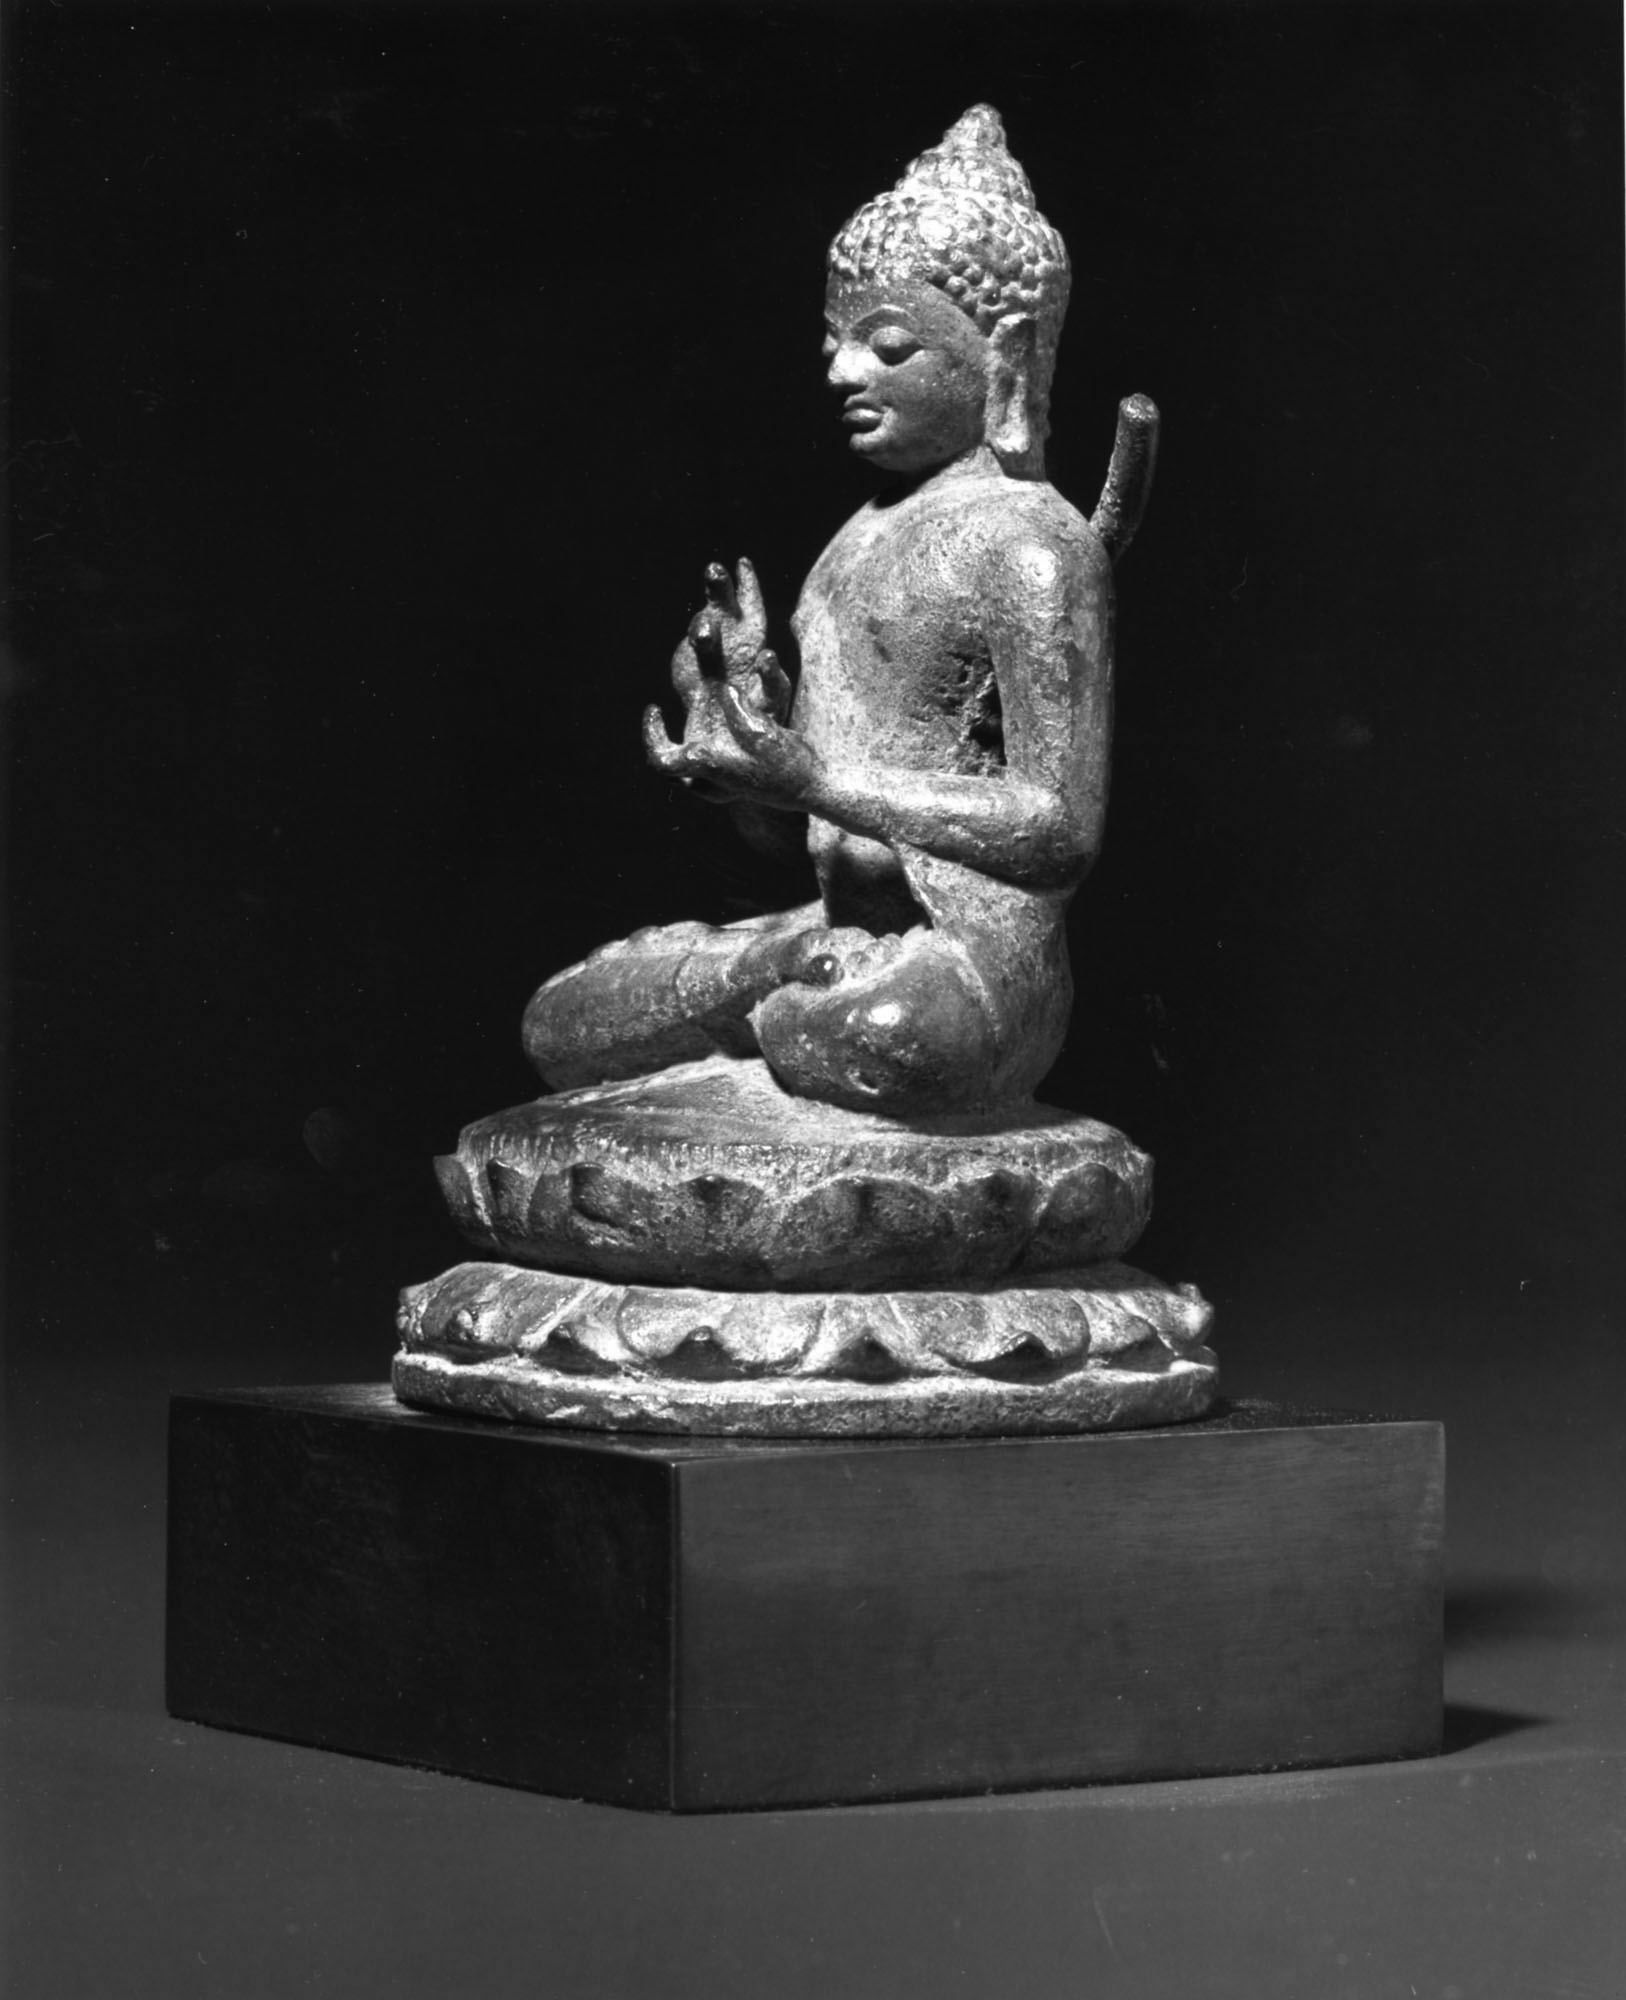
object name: figurine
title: Seated Buddha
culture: indonesian, javanese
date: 801-900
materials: bronze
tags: buddhism,buddha